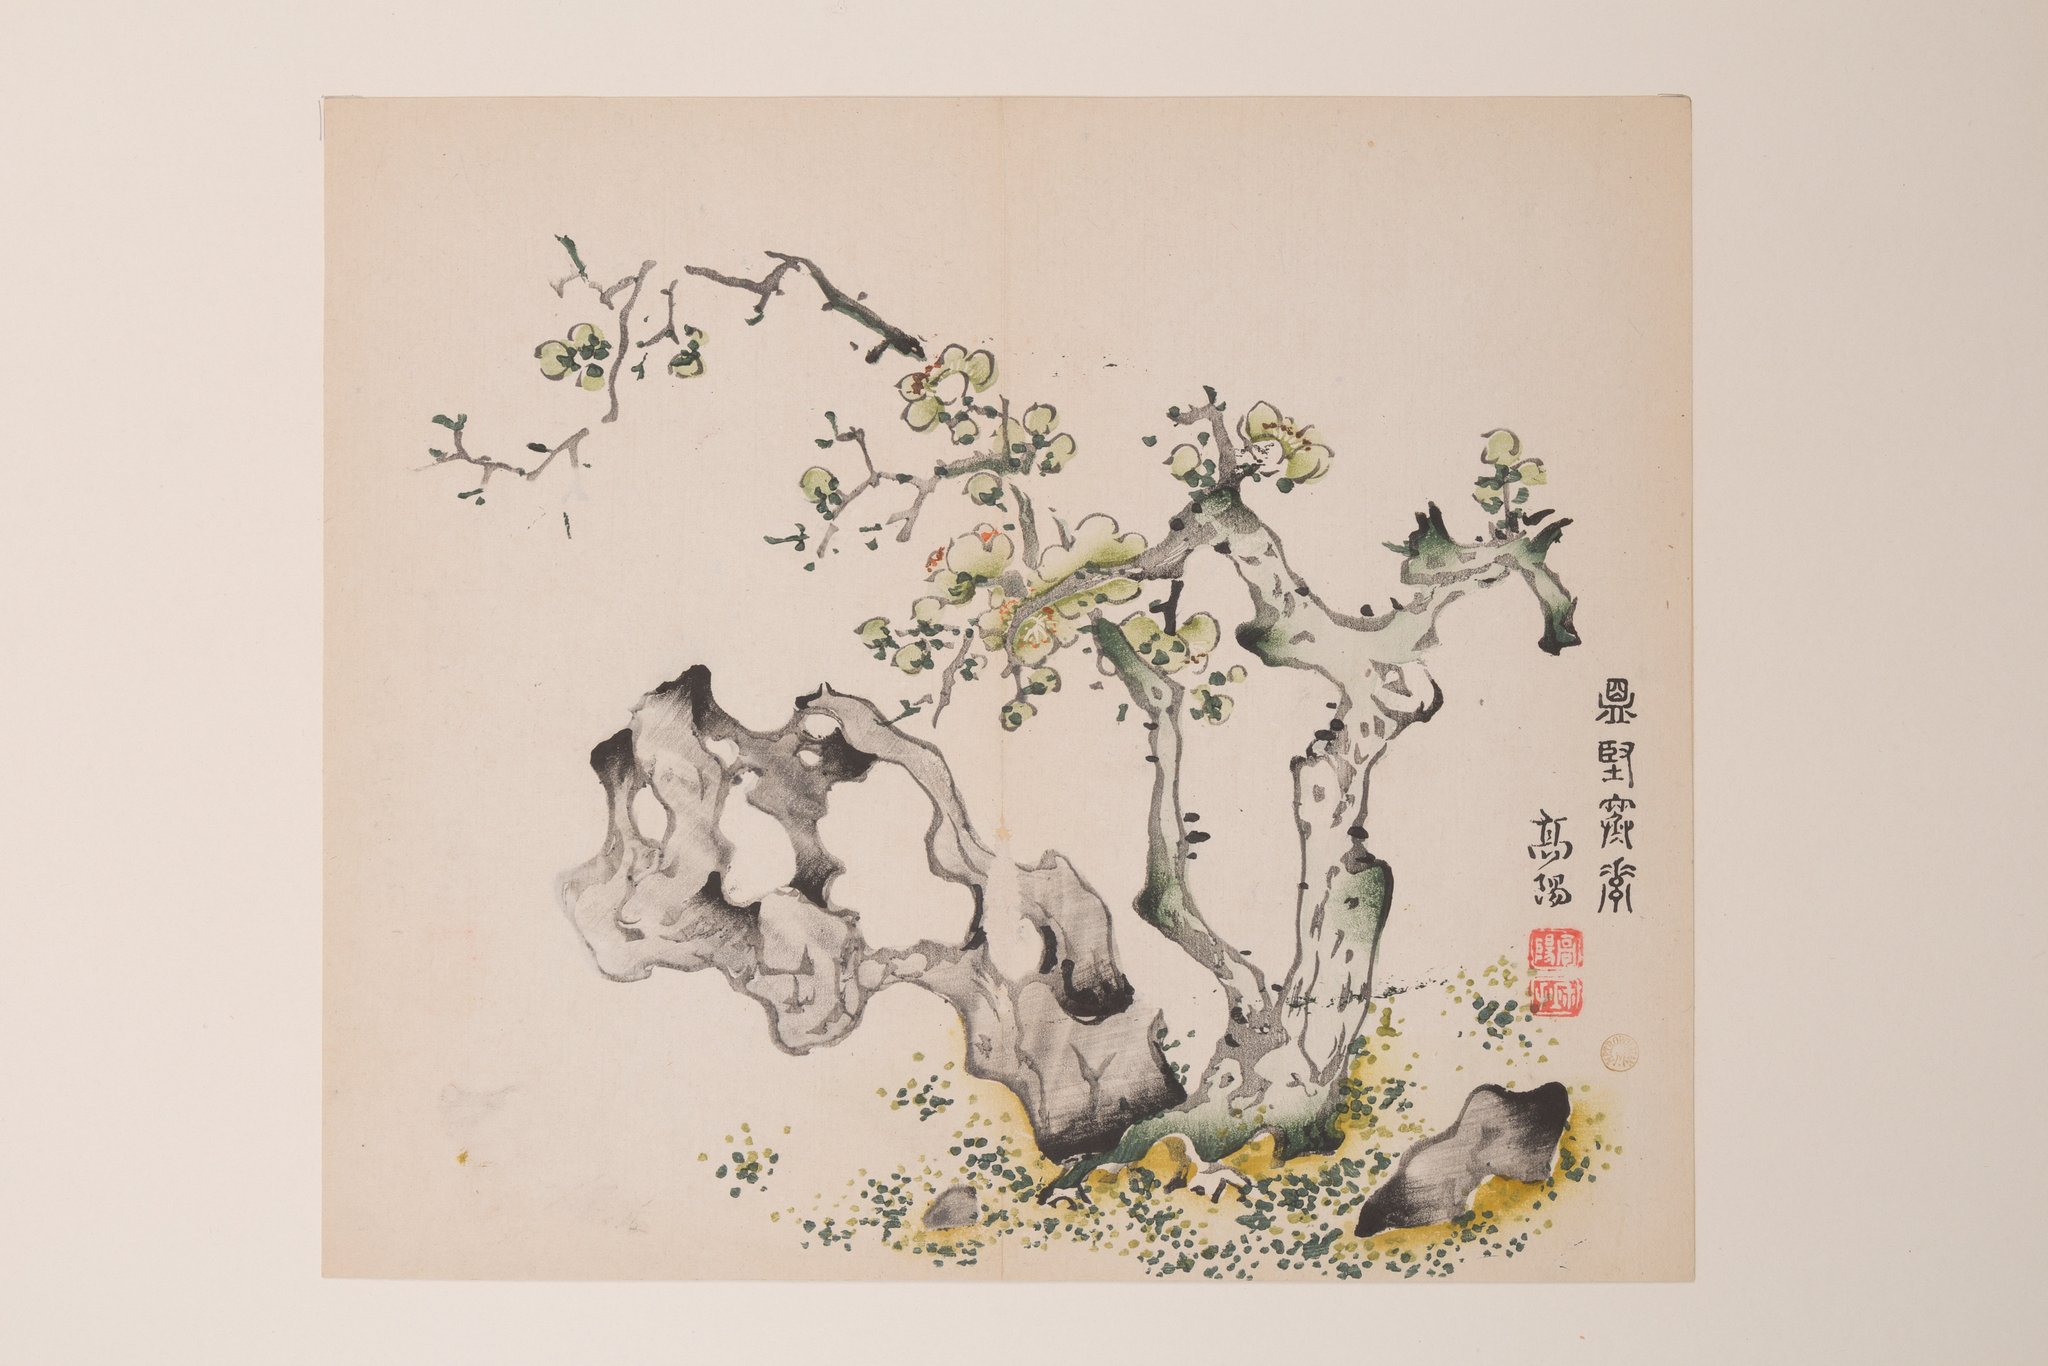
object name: print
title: Page from the Ten Bamboo Studio Manual of Painting and Calligraphy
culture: chinese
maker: hu zhengyan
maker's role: artist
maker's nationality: chinese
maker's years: 1584-1634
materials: ink, paper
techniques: printing